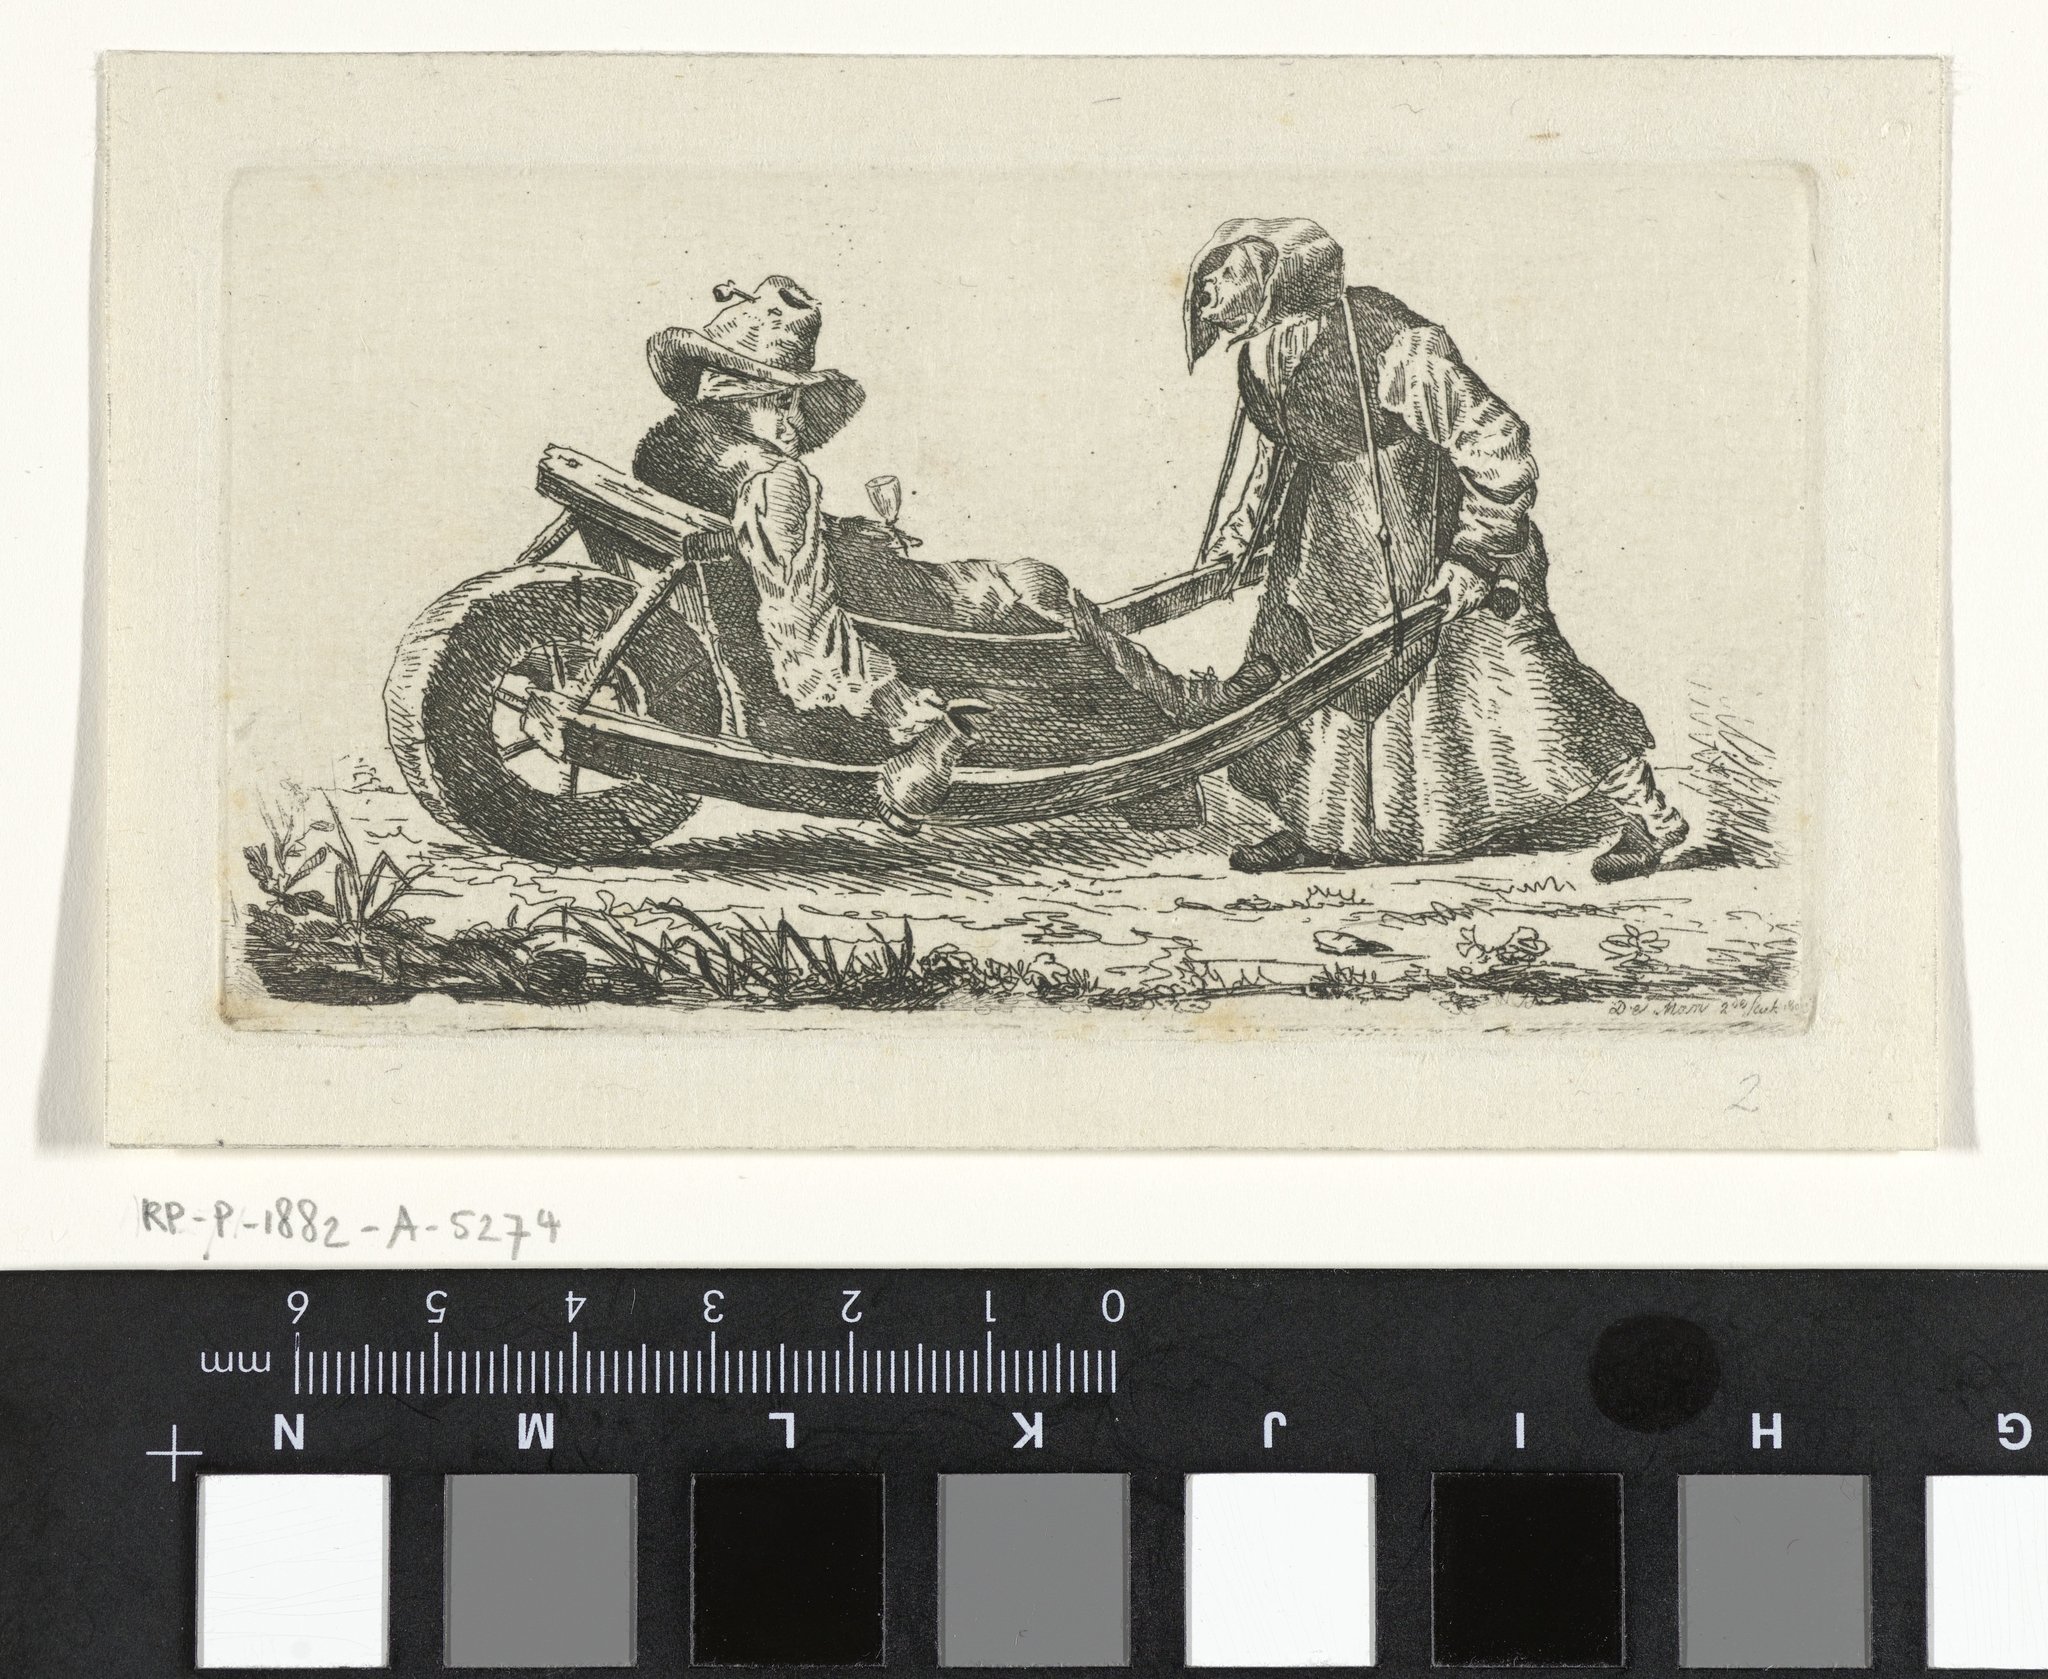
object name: print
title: Dronkaard in een kruiwagen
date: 1803-1842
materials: paper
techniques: etching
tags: pushing something - aa - female human figure, old woman, drunkenness, wheelbarrow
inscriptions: collector's mark: Lugt 2227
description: Een man met kan en glas in de handen wordt door een oude vrouw naar links voortgeduwd in een kruiwagen.